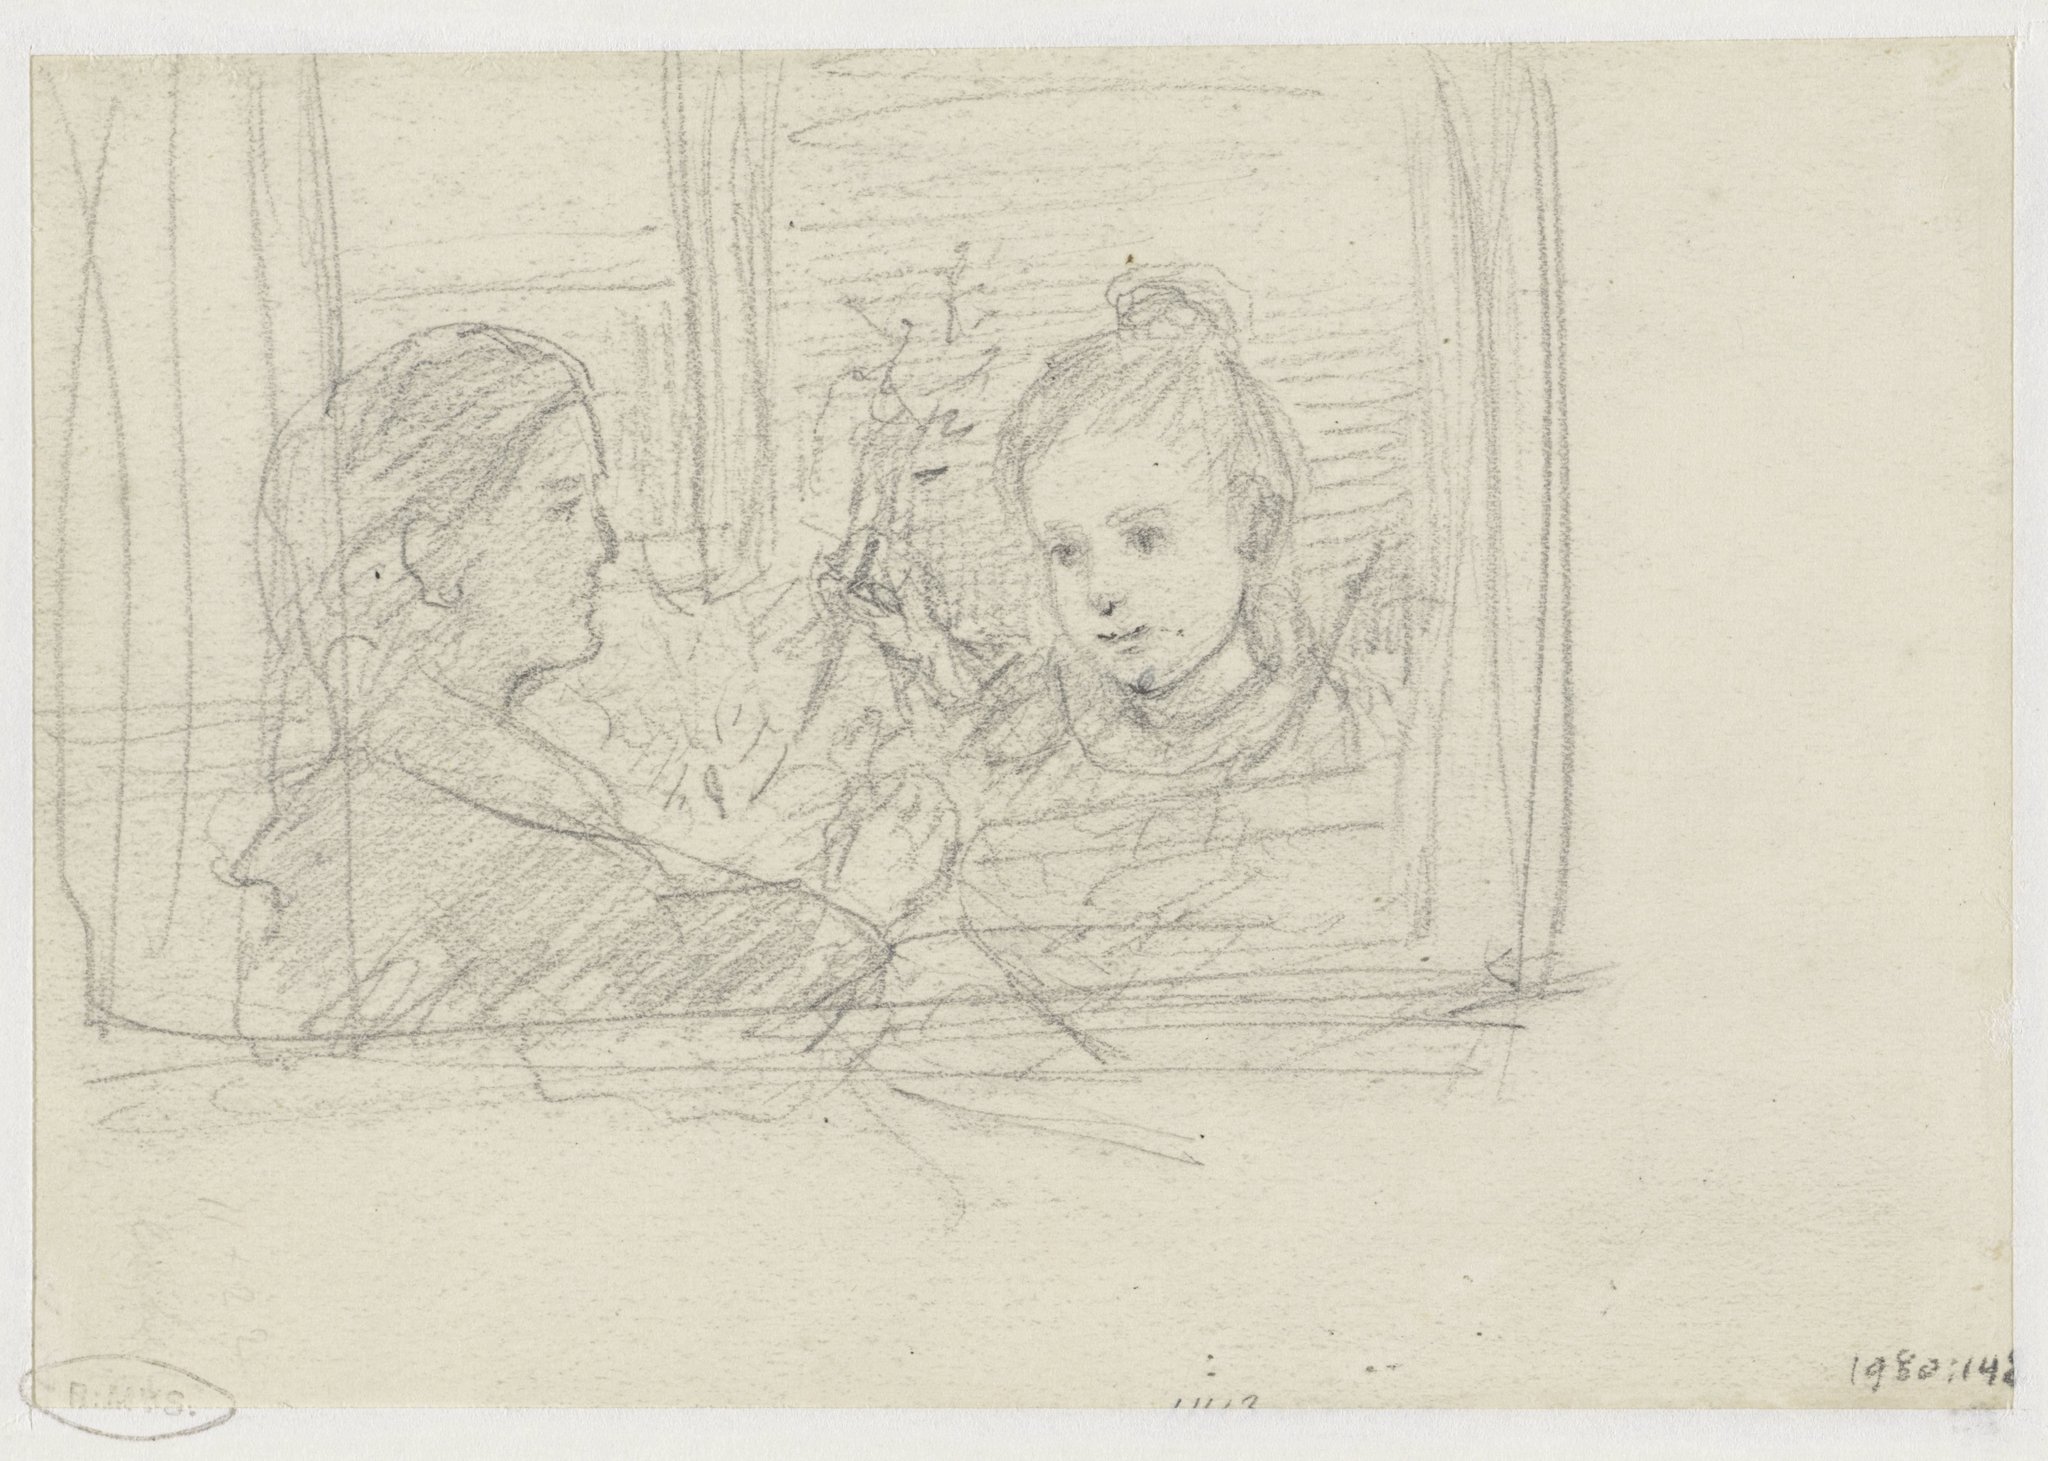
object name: drawing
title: Vrouw en een meisje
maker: jozef israëls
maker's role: draughtsman, painter, print maker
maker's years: 1824-1911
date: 1834-1911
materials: paper, pencil